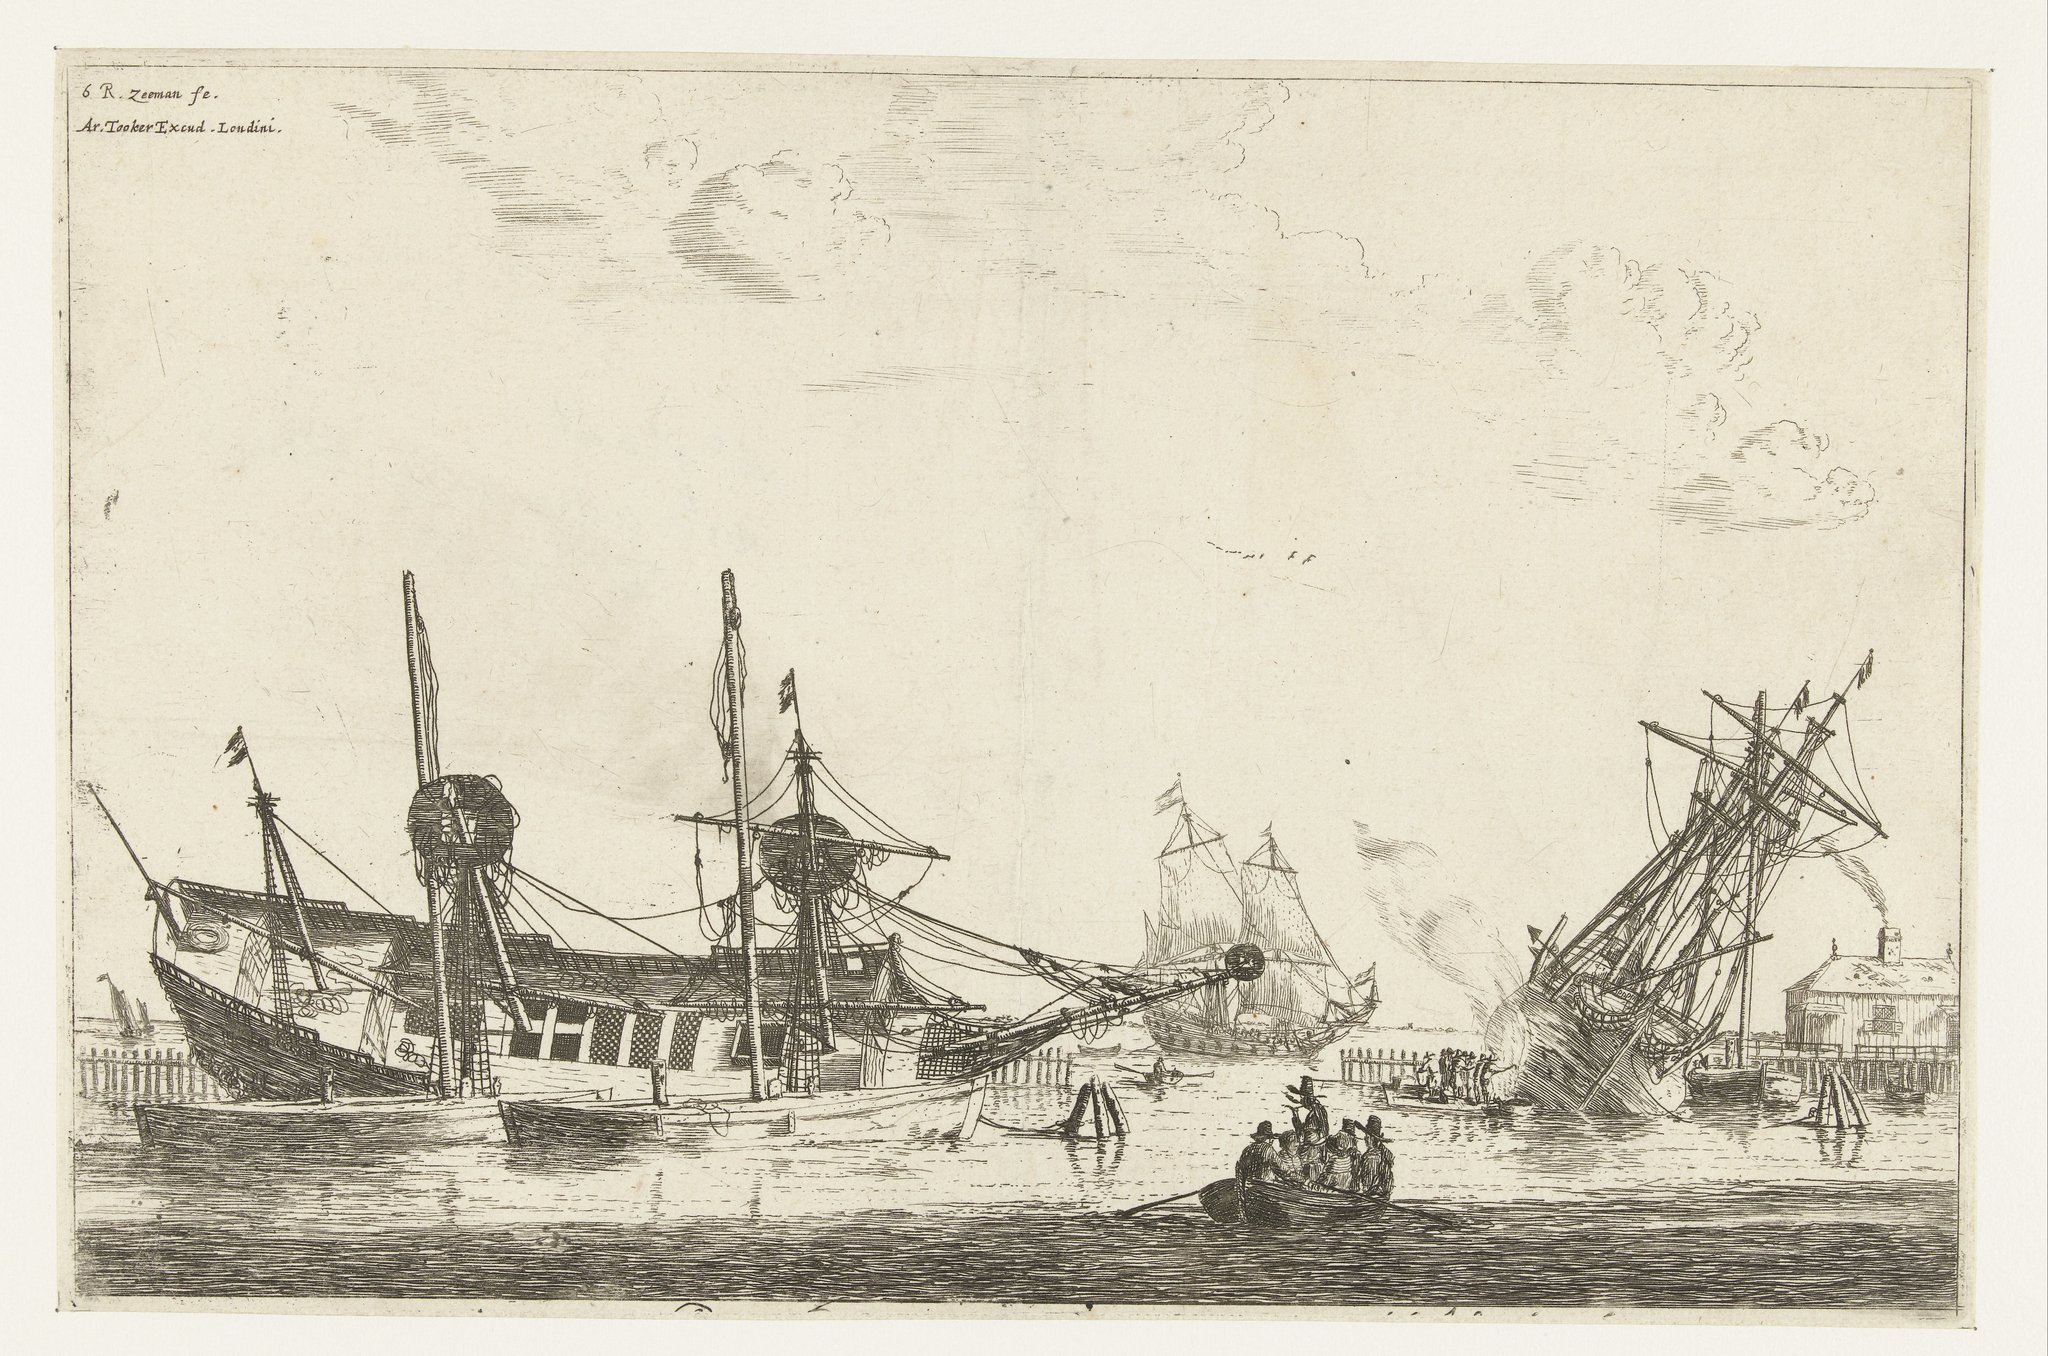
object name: print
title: Twee gekielde zeilschepen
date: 1650-1675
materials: paper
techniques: etching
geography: netherlands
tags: repairing, caulking, careening (~ ship)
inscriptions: collector's mark: Lugt 2228a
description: Een werf met twee onderleggers die een groot zeilschip kielen, een gekield schip met mannen die werken aan het waterdichtmaken van de romp en een roeiboot met een aantal mensen erin. Buiten de golfbreker nog een aantal zeilschepen op het water.